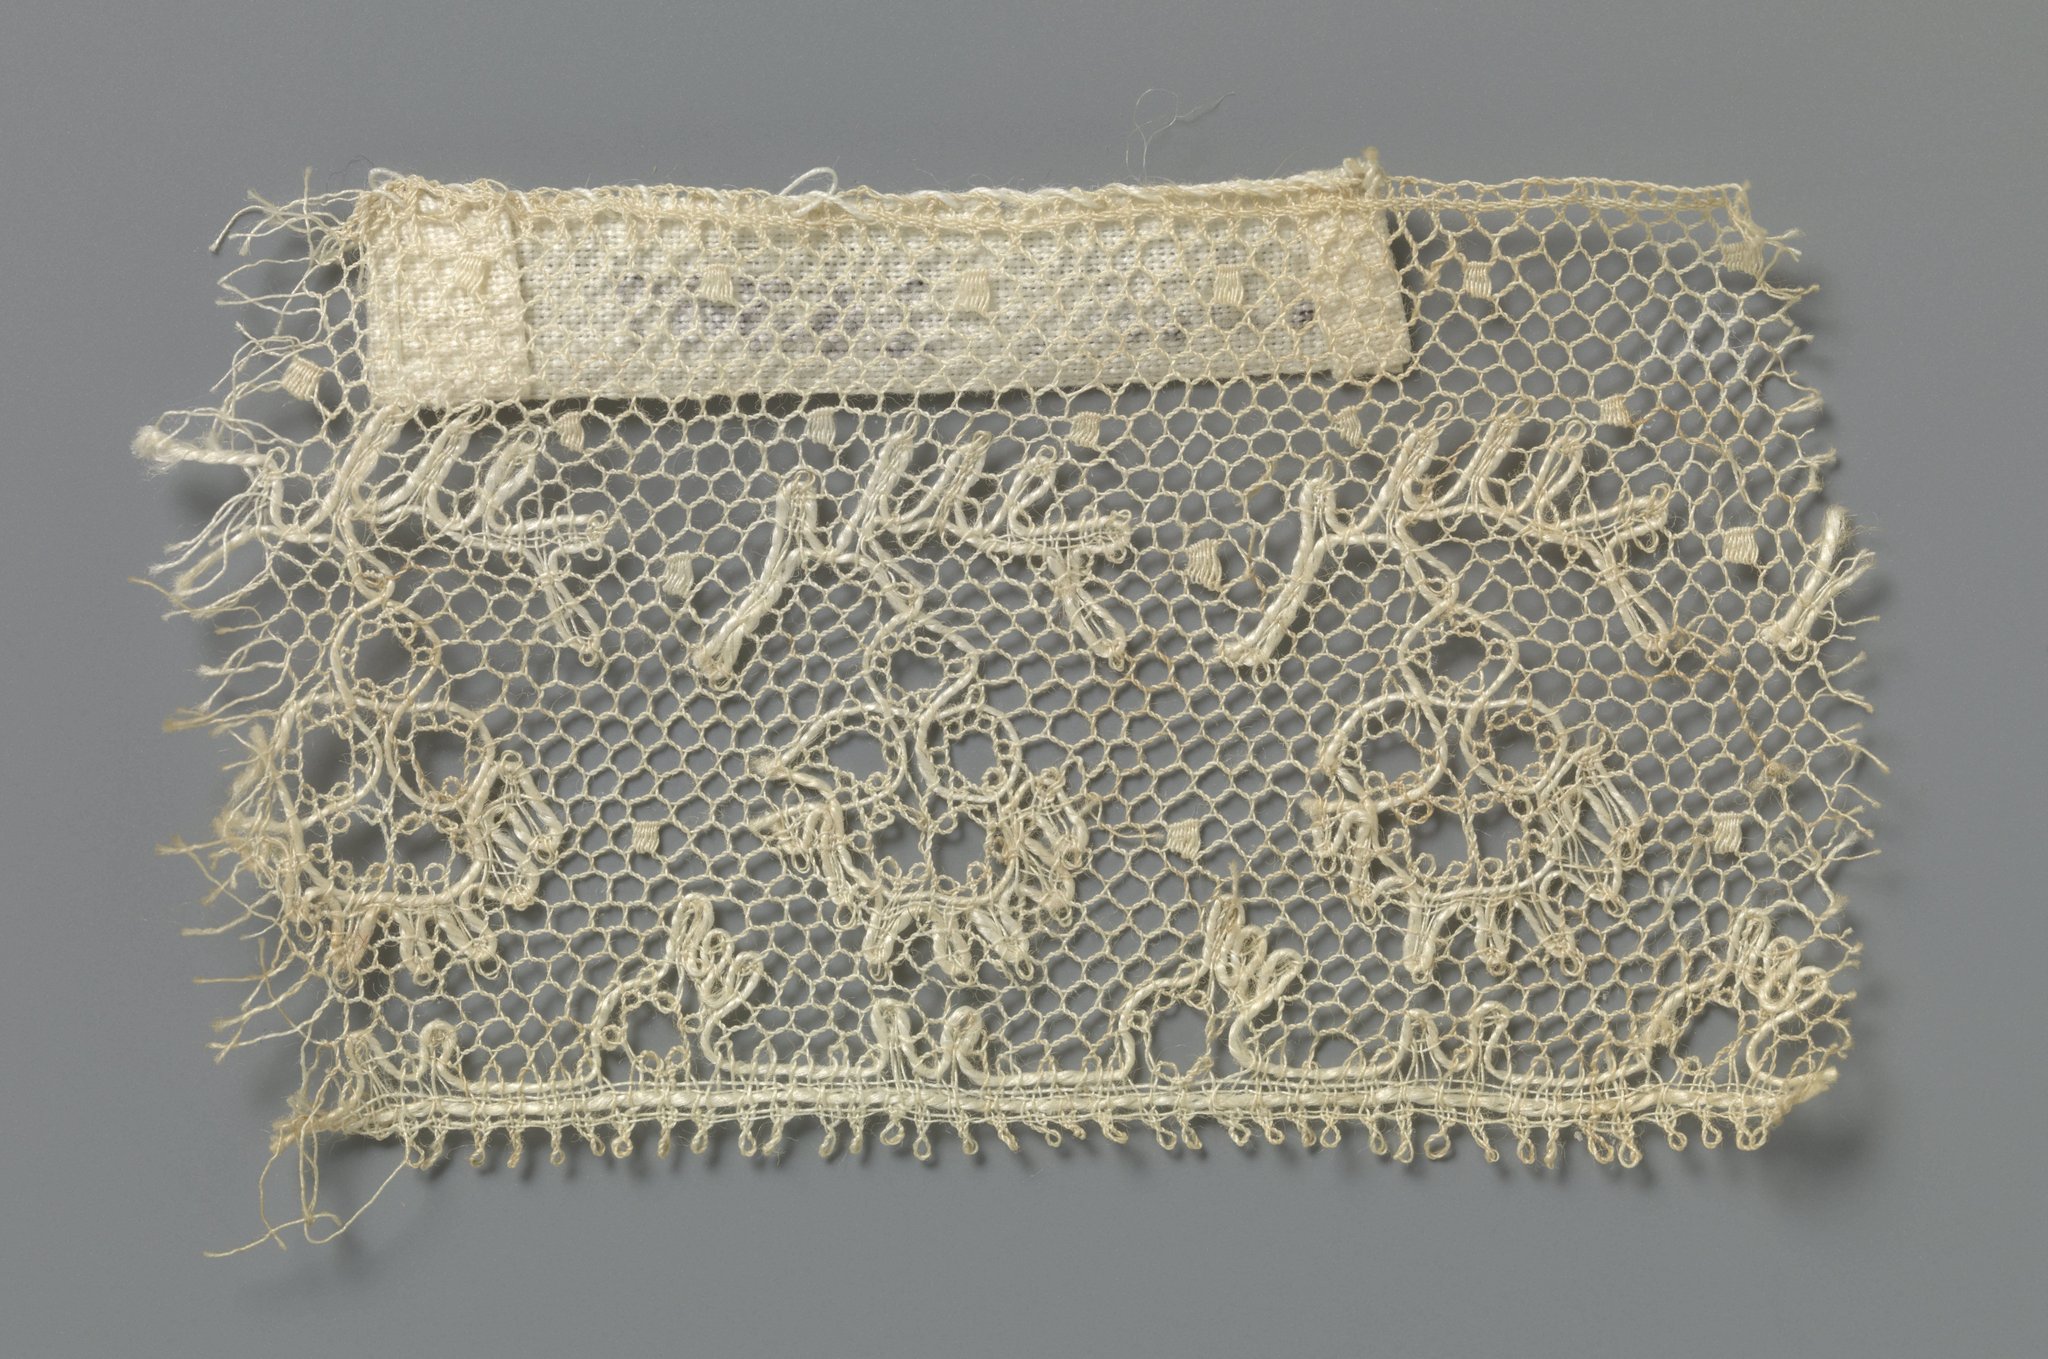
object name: strip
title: Strook kloskant met bloem onder gebogen blad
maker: Anonymous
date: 1900-1924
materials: linen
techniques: lace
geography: belgium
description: Strook naturelkleurige kloskant, Rijselse kant. Het zich herhalende patroon bestaat uit een takje met een gebogen blad waaronder een bloem hangt. De bloem bestaat uit vijf cirkeltjes gemaakt met een siergrond, een rozengrond, en een randje met grillige lobjes. Langs de onderzijde van de strook ligt steeds tussen de opeenvolgende bloemen één cirkeltje met een paar lobjes. De motieven zijn met elkaar verbonden door een maasgrond, een tulegrond, bezaaid met vierkante moesjes. Het zeer spaarzame volwerk is gemaakt in linnenslag, waarbij de dikkere en glimmende contourdraden overheersen. De moesjes zijn gemaakt in vormslag. De boven- en onderzijde van de strook zijn recht afgewerkt, waarbij de onderzijde is voorzien van picots.